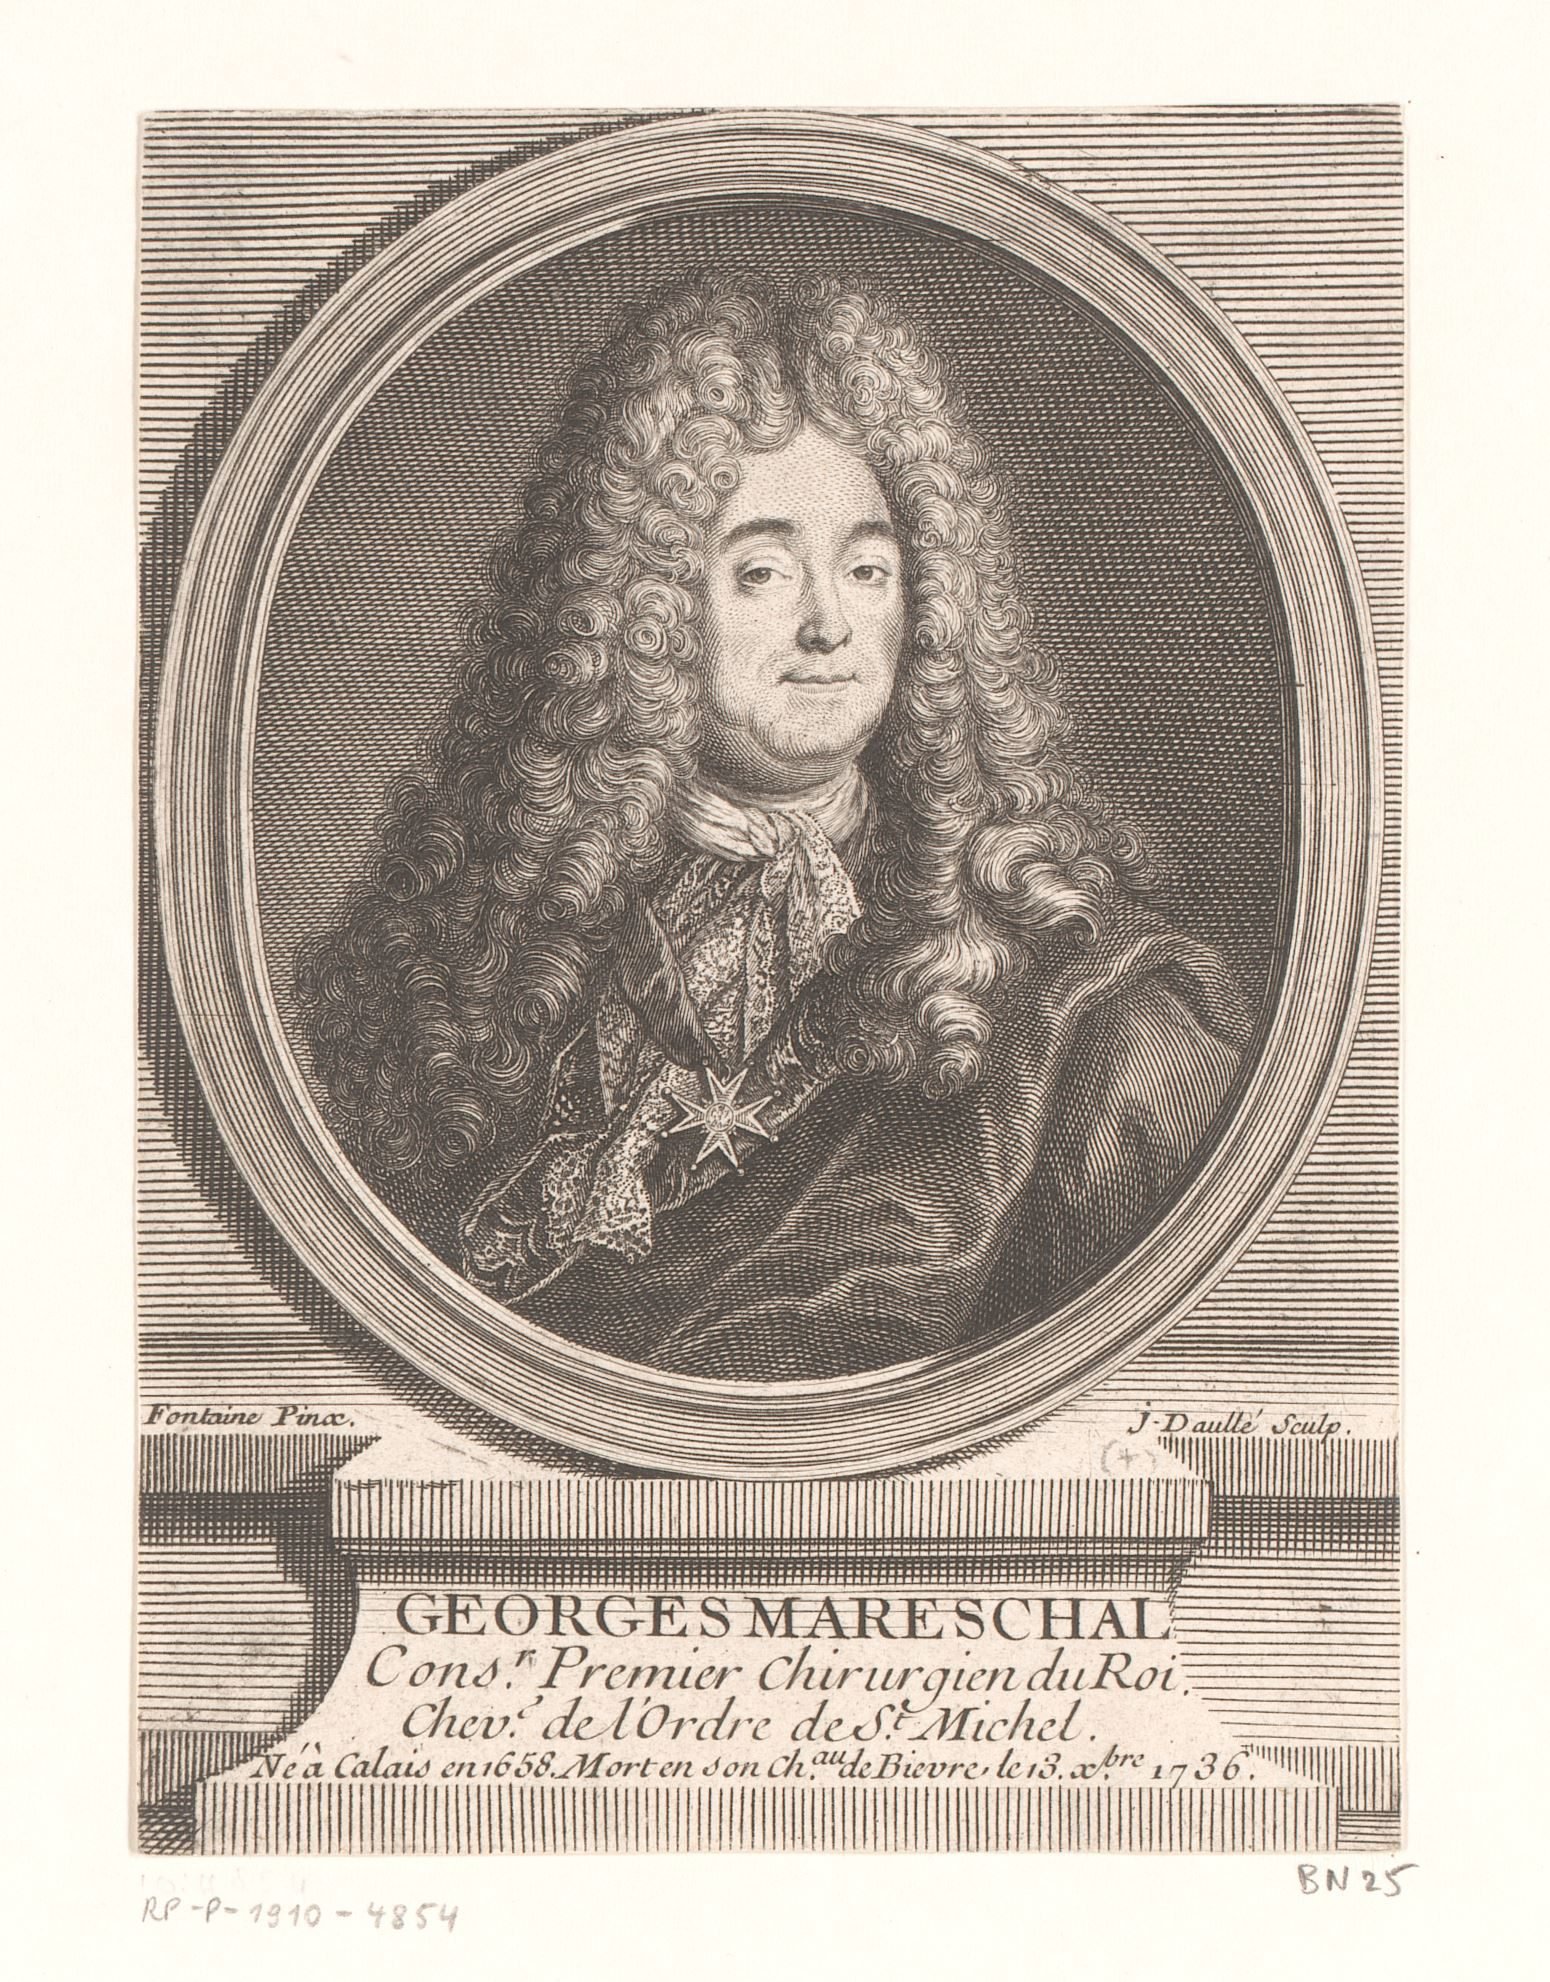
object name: print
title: Georges Mareschal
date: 1736-1763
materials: paper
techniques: engraving, etching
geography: france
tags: ornament ~ medallion, historical persons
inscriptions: collector's mark: Lugt 2228